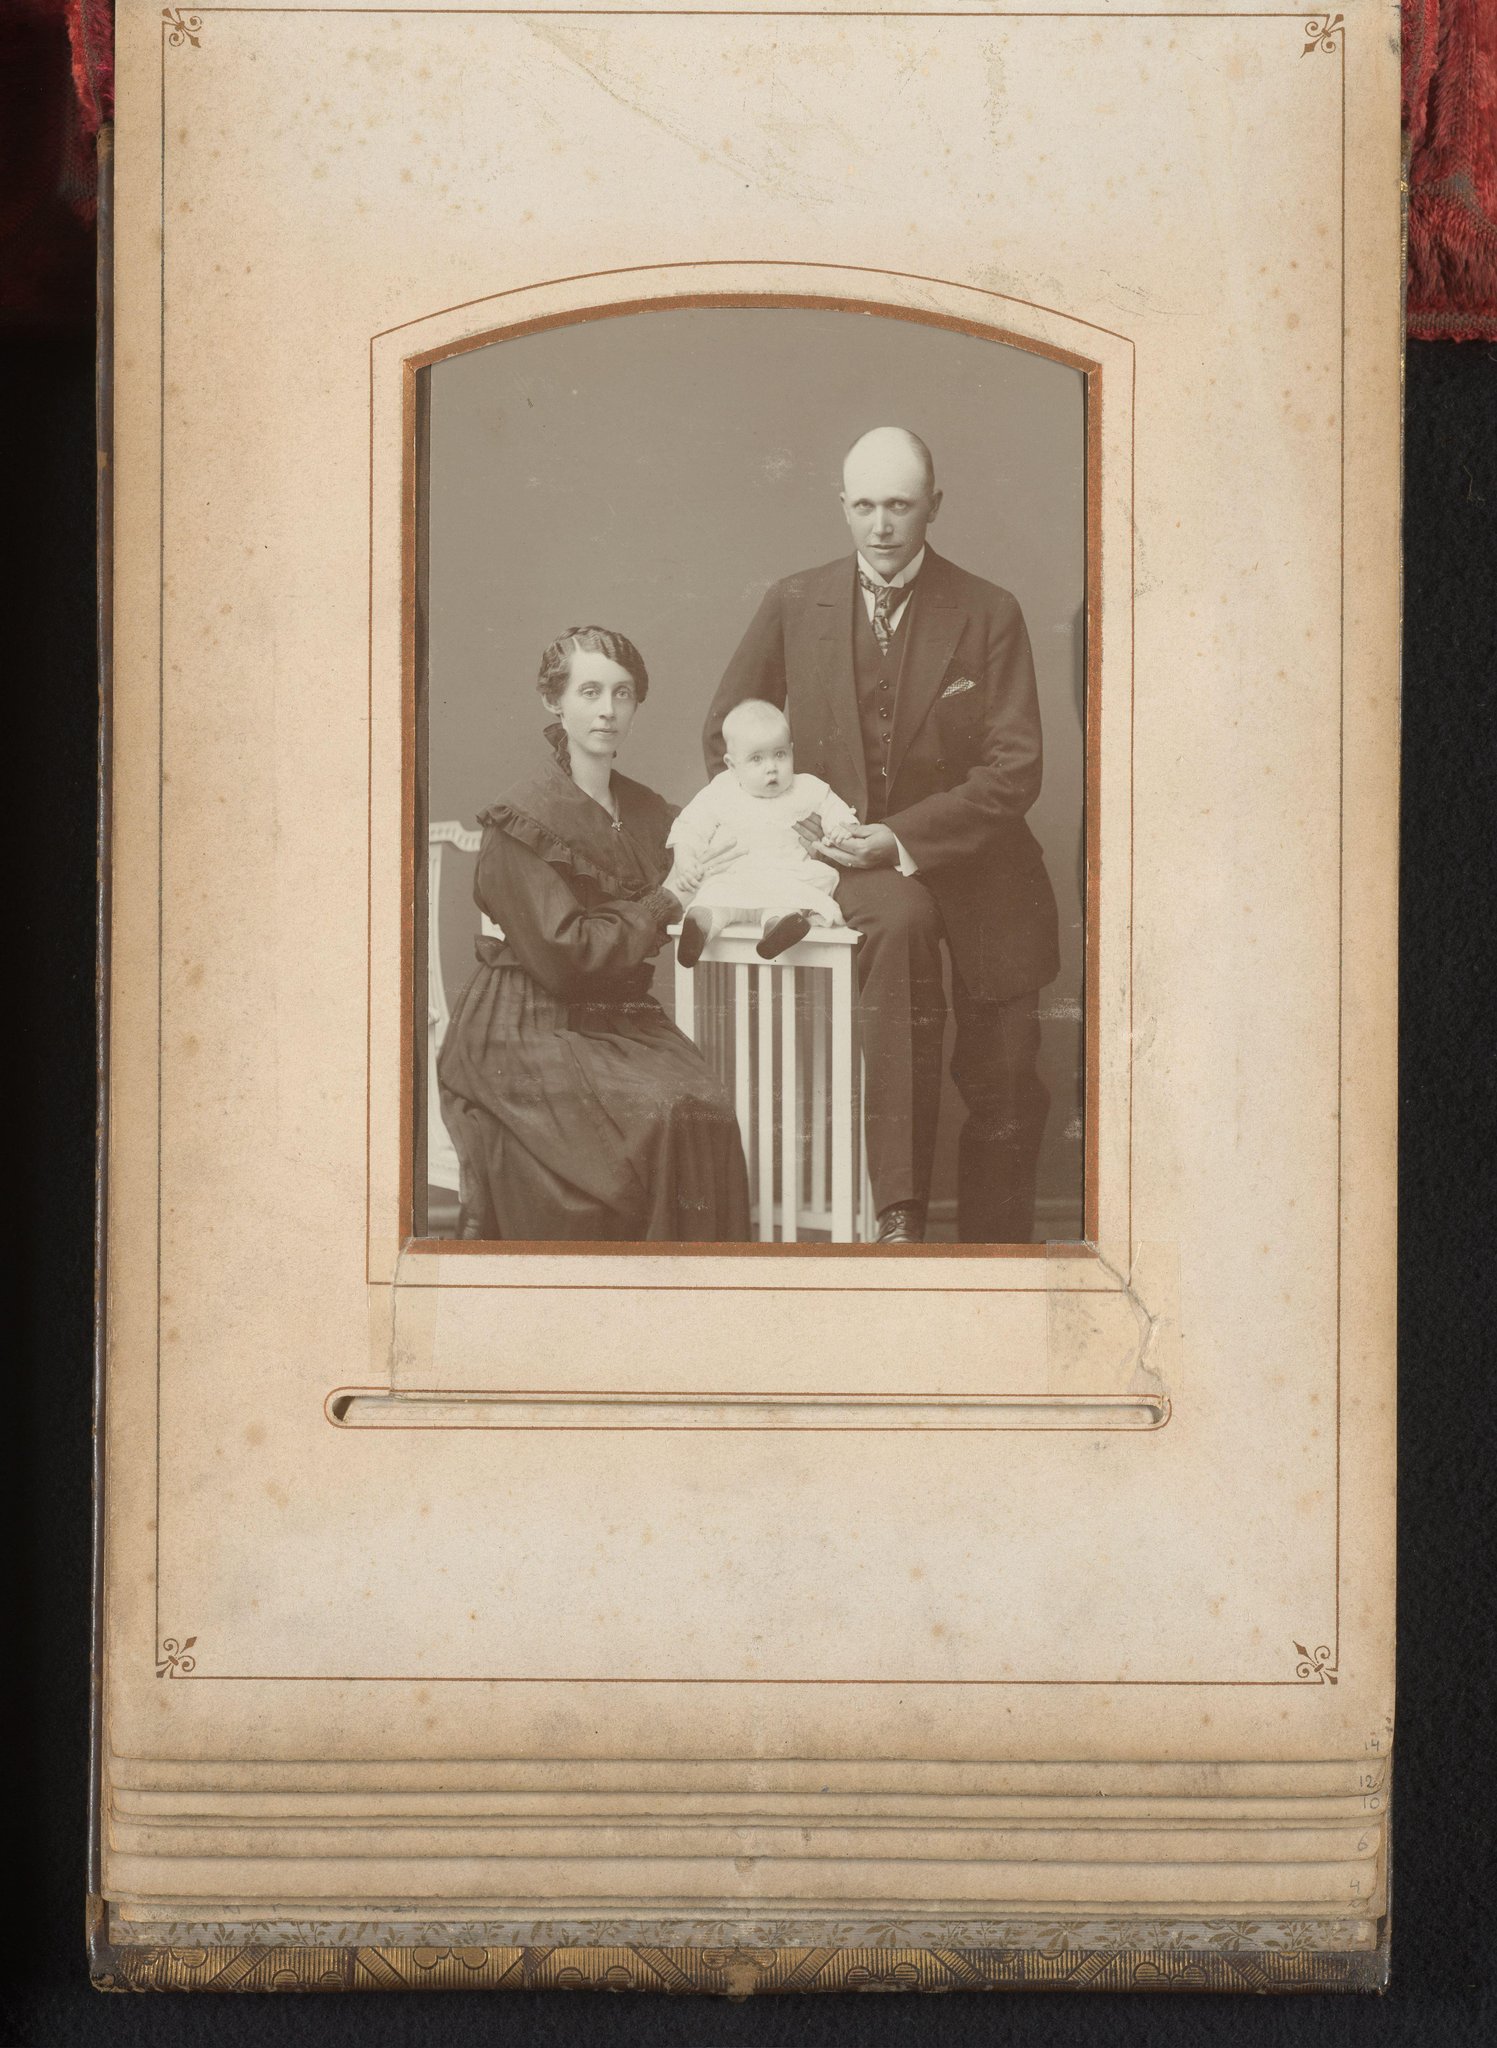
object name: photograph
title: Portret van een staande man, een zittende vrouw en een baby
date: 1880-1920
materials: cardboard, photographic support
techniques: collodion silver print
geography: stockholm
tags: historical persons - bb - woman, historical persons, infant, baby ~ the ages of man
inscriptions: inscription: ‘ATELIER GÖTA/ Götgatan 21/ Stockholm’